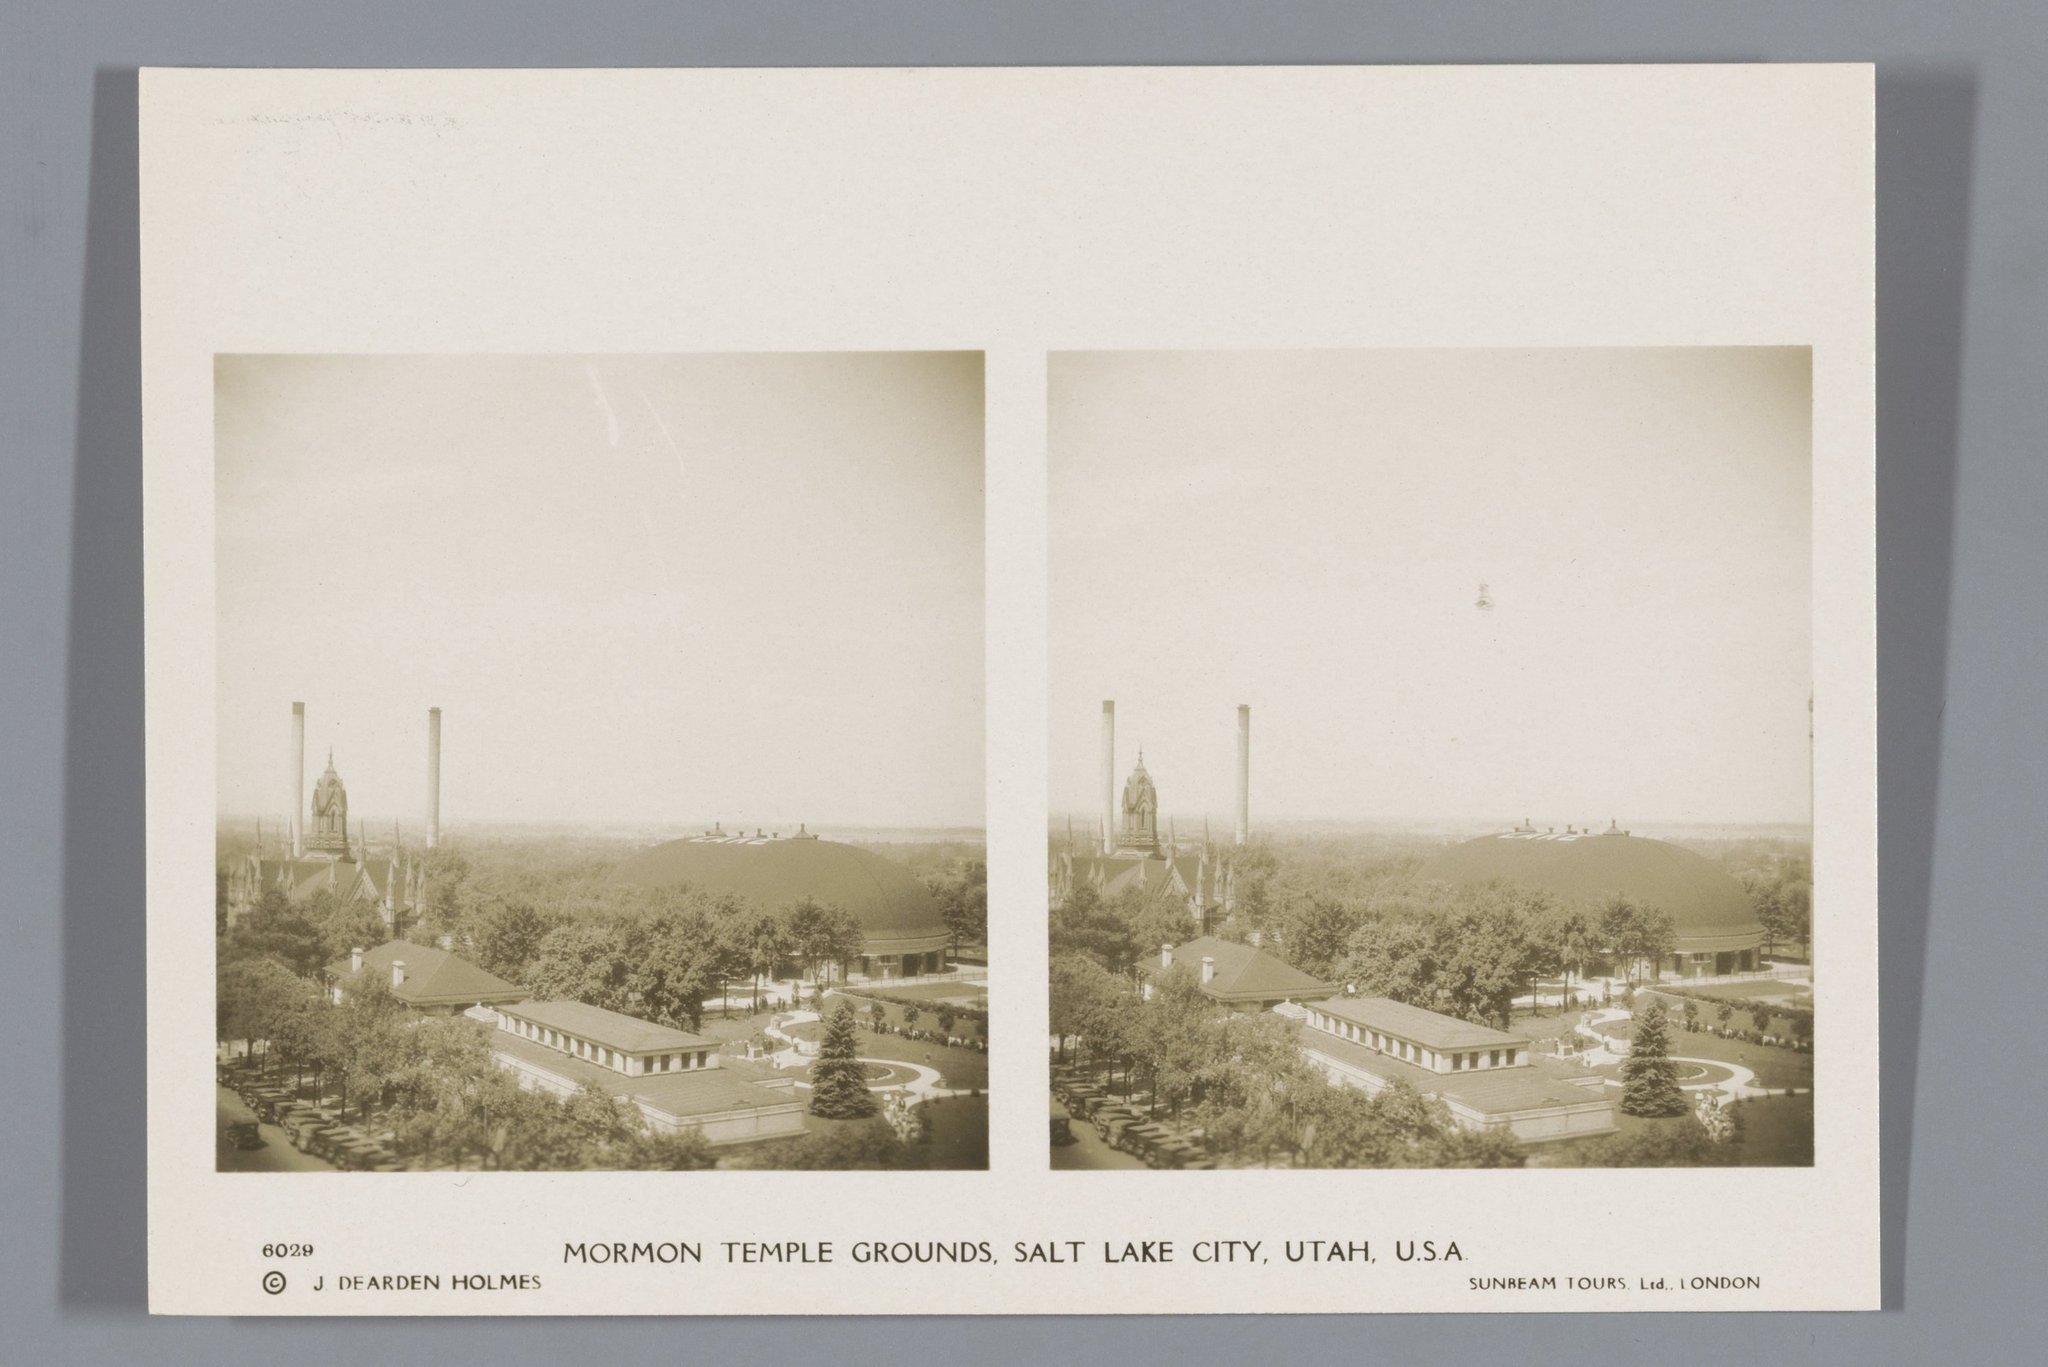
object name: stereograph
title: 6 "Picturescope" Views of Salt Lake City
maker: james dearden holmes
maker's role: fotograaf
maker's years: 1873-1937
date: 1924-1926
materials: paper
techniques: gelatin silver print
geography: salt lake city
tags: movements derived from protestant churches (with name)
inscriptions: number: ‘6029’